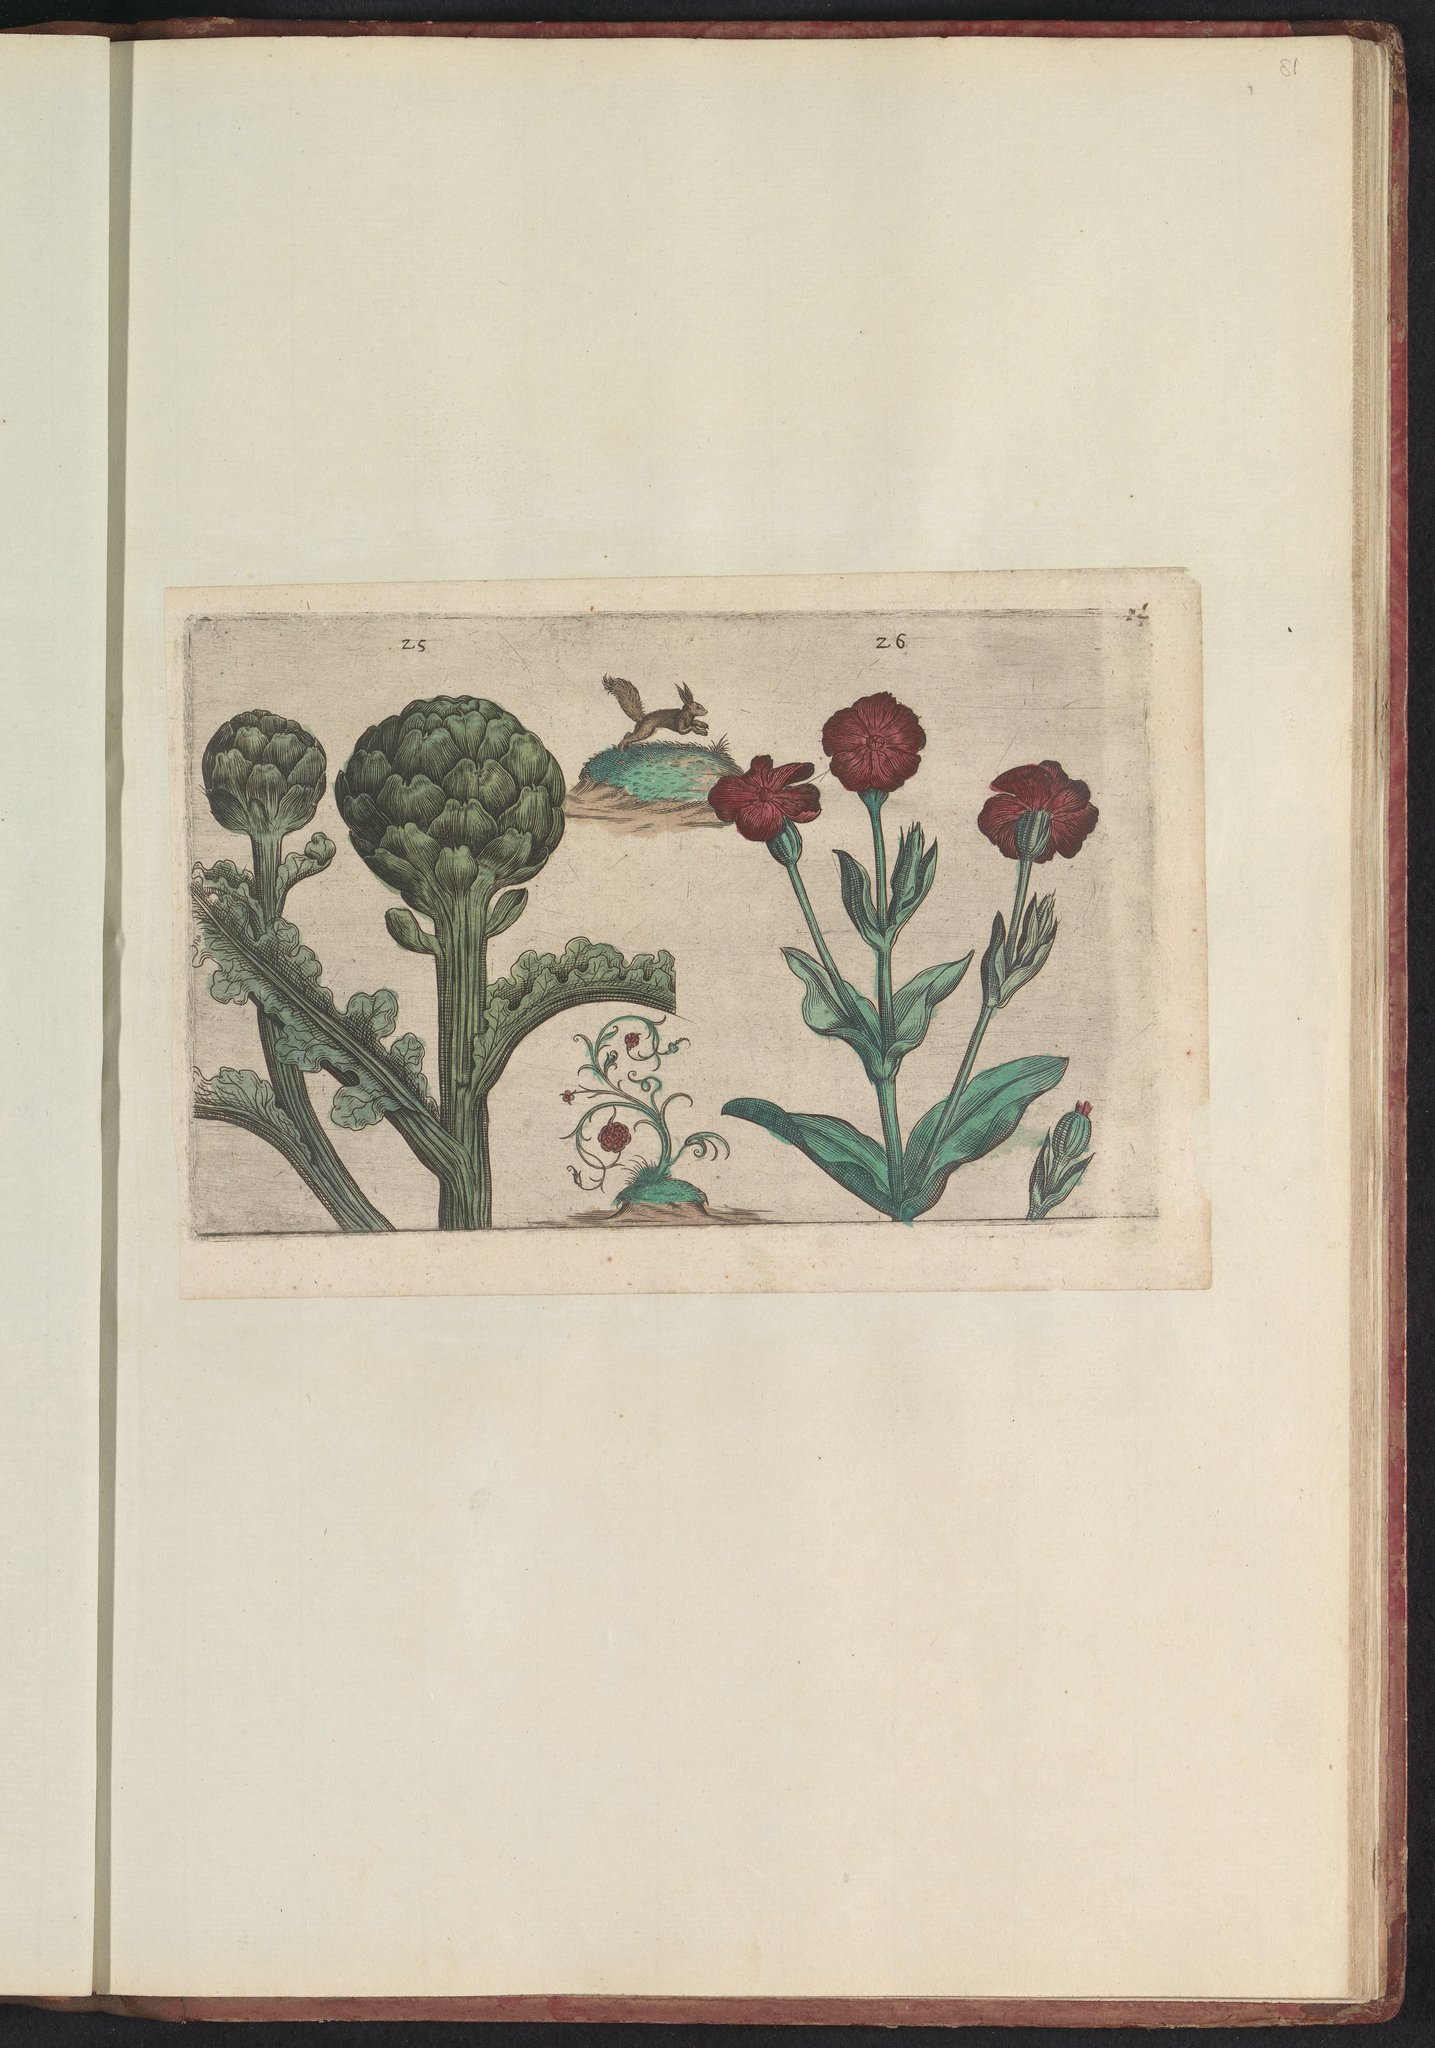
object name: print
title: Artisjok (Cynara cardunculus) en prikneus (Silene coronaria)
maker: Anonymous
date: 1604-1632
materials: ink, paper, watercolor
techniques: engraving, hand coloring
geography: cologne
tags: flowers: silene coronaria, rodents: squirrel, plants and herbs: artichoke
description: Artisjok en prikneus. Met een springende eekhoorn en een ornamentele plant. Figs. 25 en 26 op een blad met de hand genummerd 14. In: Anselmi Boëtii de Boot I.C. Brugensis & Rodolphi II. Imp. Roman. medici a cubiculis Florum, Herbarum, ac fructuum selectiorum icones, & vires pleraeque hactenus ignotæ. Onderdeel van het album met bladen en platen uit De Boodts herbarium van 1640. Het twaalfde van twaalf albums met aquarellen van dieren, vogels en planten bekend rond 1600, gemaakt in opdracht van keizer Rudolf II.